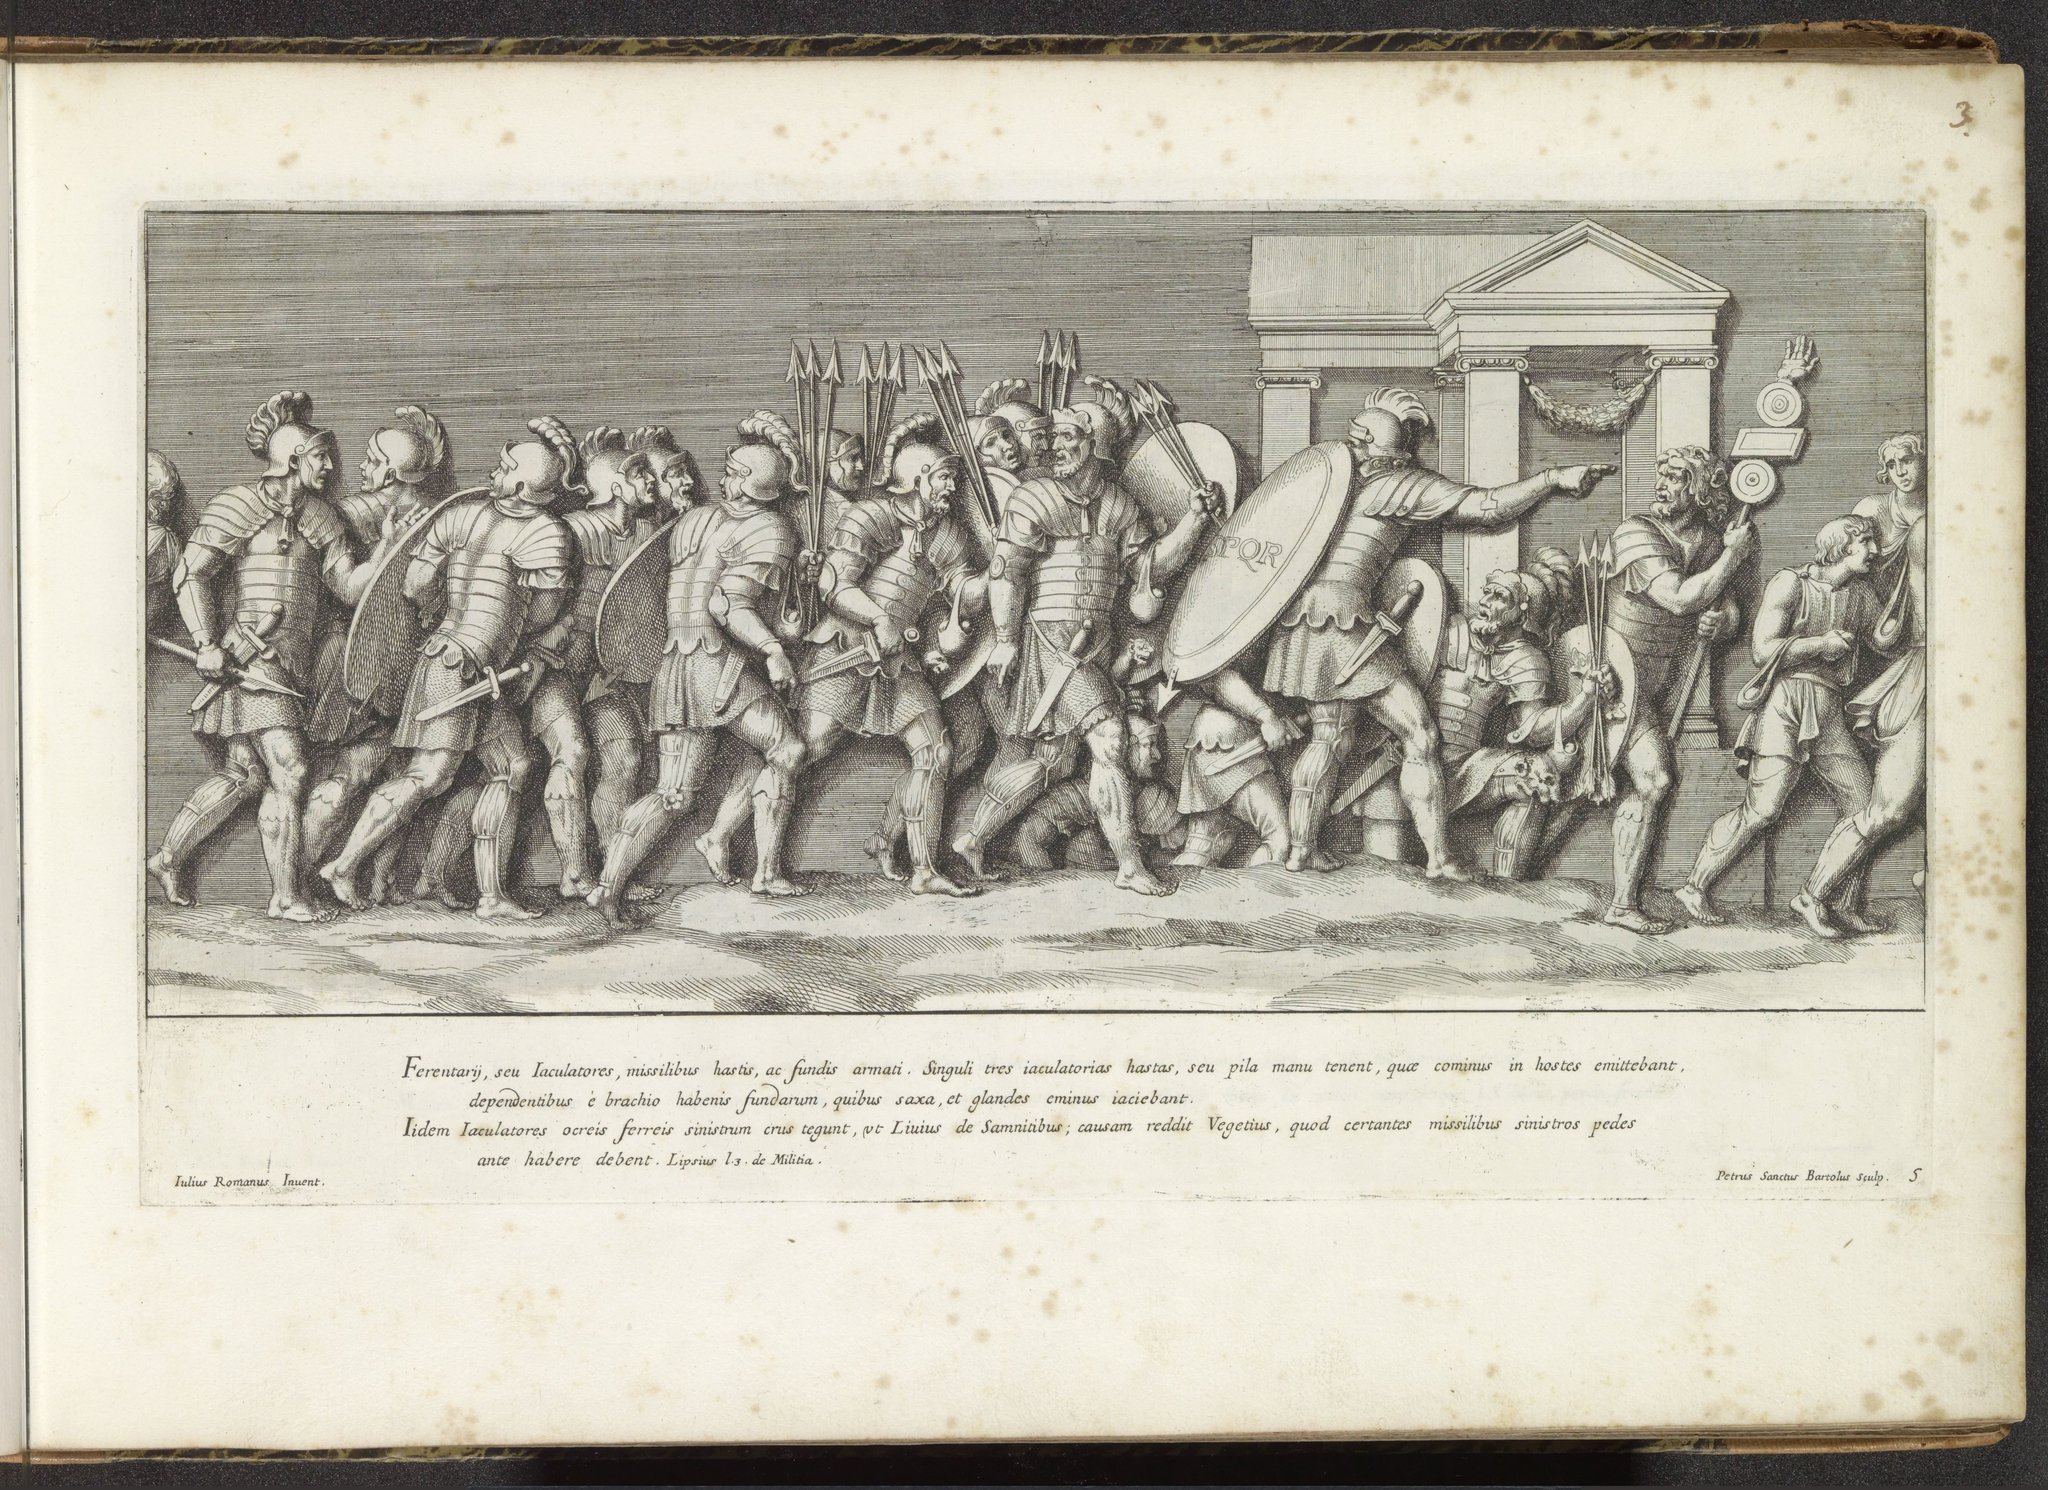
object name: print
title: Stucwerk in de Sala degli Stucchi in Palazzo del Te te Mantua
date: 1680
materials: paper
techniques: etching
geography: vatican city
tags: triumphal entry and public reception, pageant, 'entrée solennelle', 'joyeuse entrée', military parade, pageant, banner, standard (as symbol of the state, etc.), the soldier; the soldier's life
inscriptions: number: ‘5’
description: Prent maakt deel uit van een reeks van 25 prenten (+ titelprent) naar het stucwerk door Giulio Romano en Francesco Primaticcio in de Sala degli Stucchi in Palazzo del Te te Mantua.